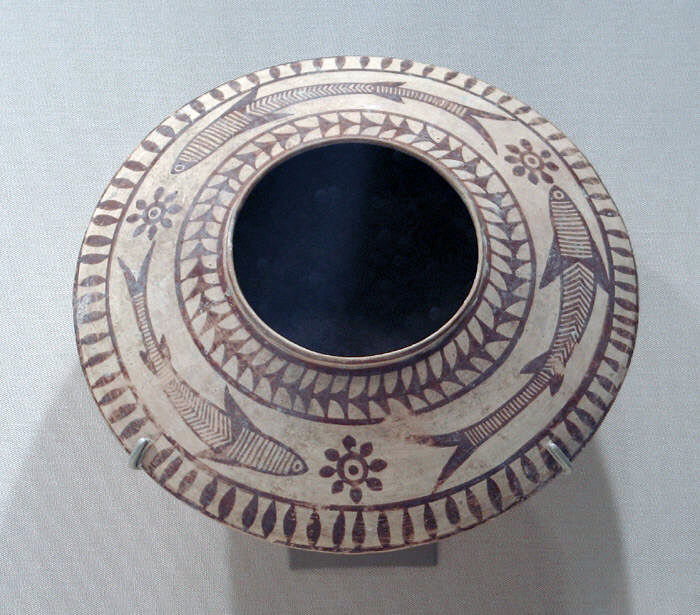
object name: vessel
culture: pakistan, baluchistan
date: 3000-2500 BCE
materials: pottery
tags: indus valley